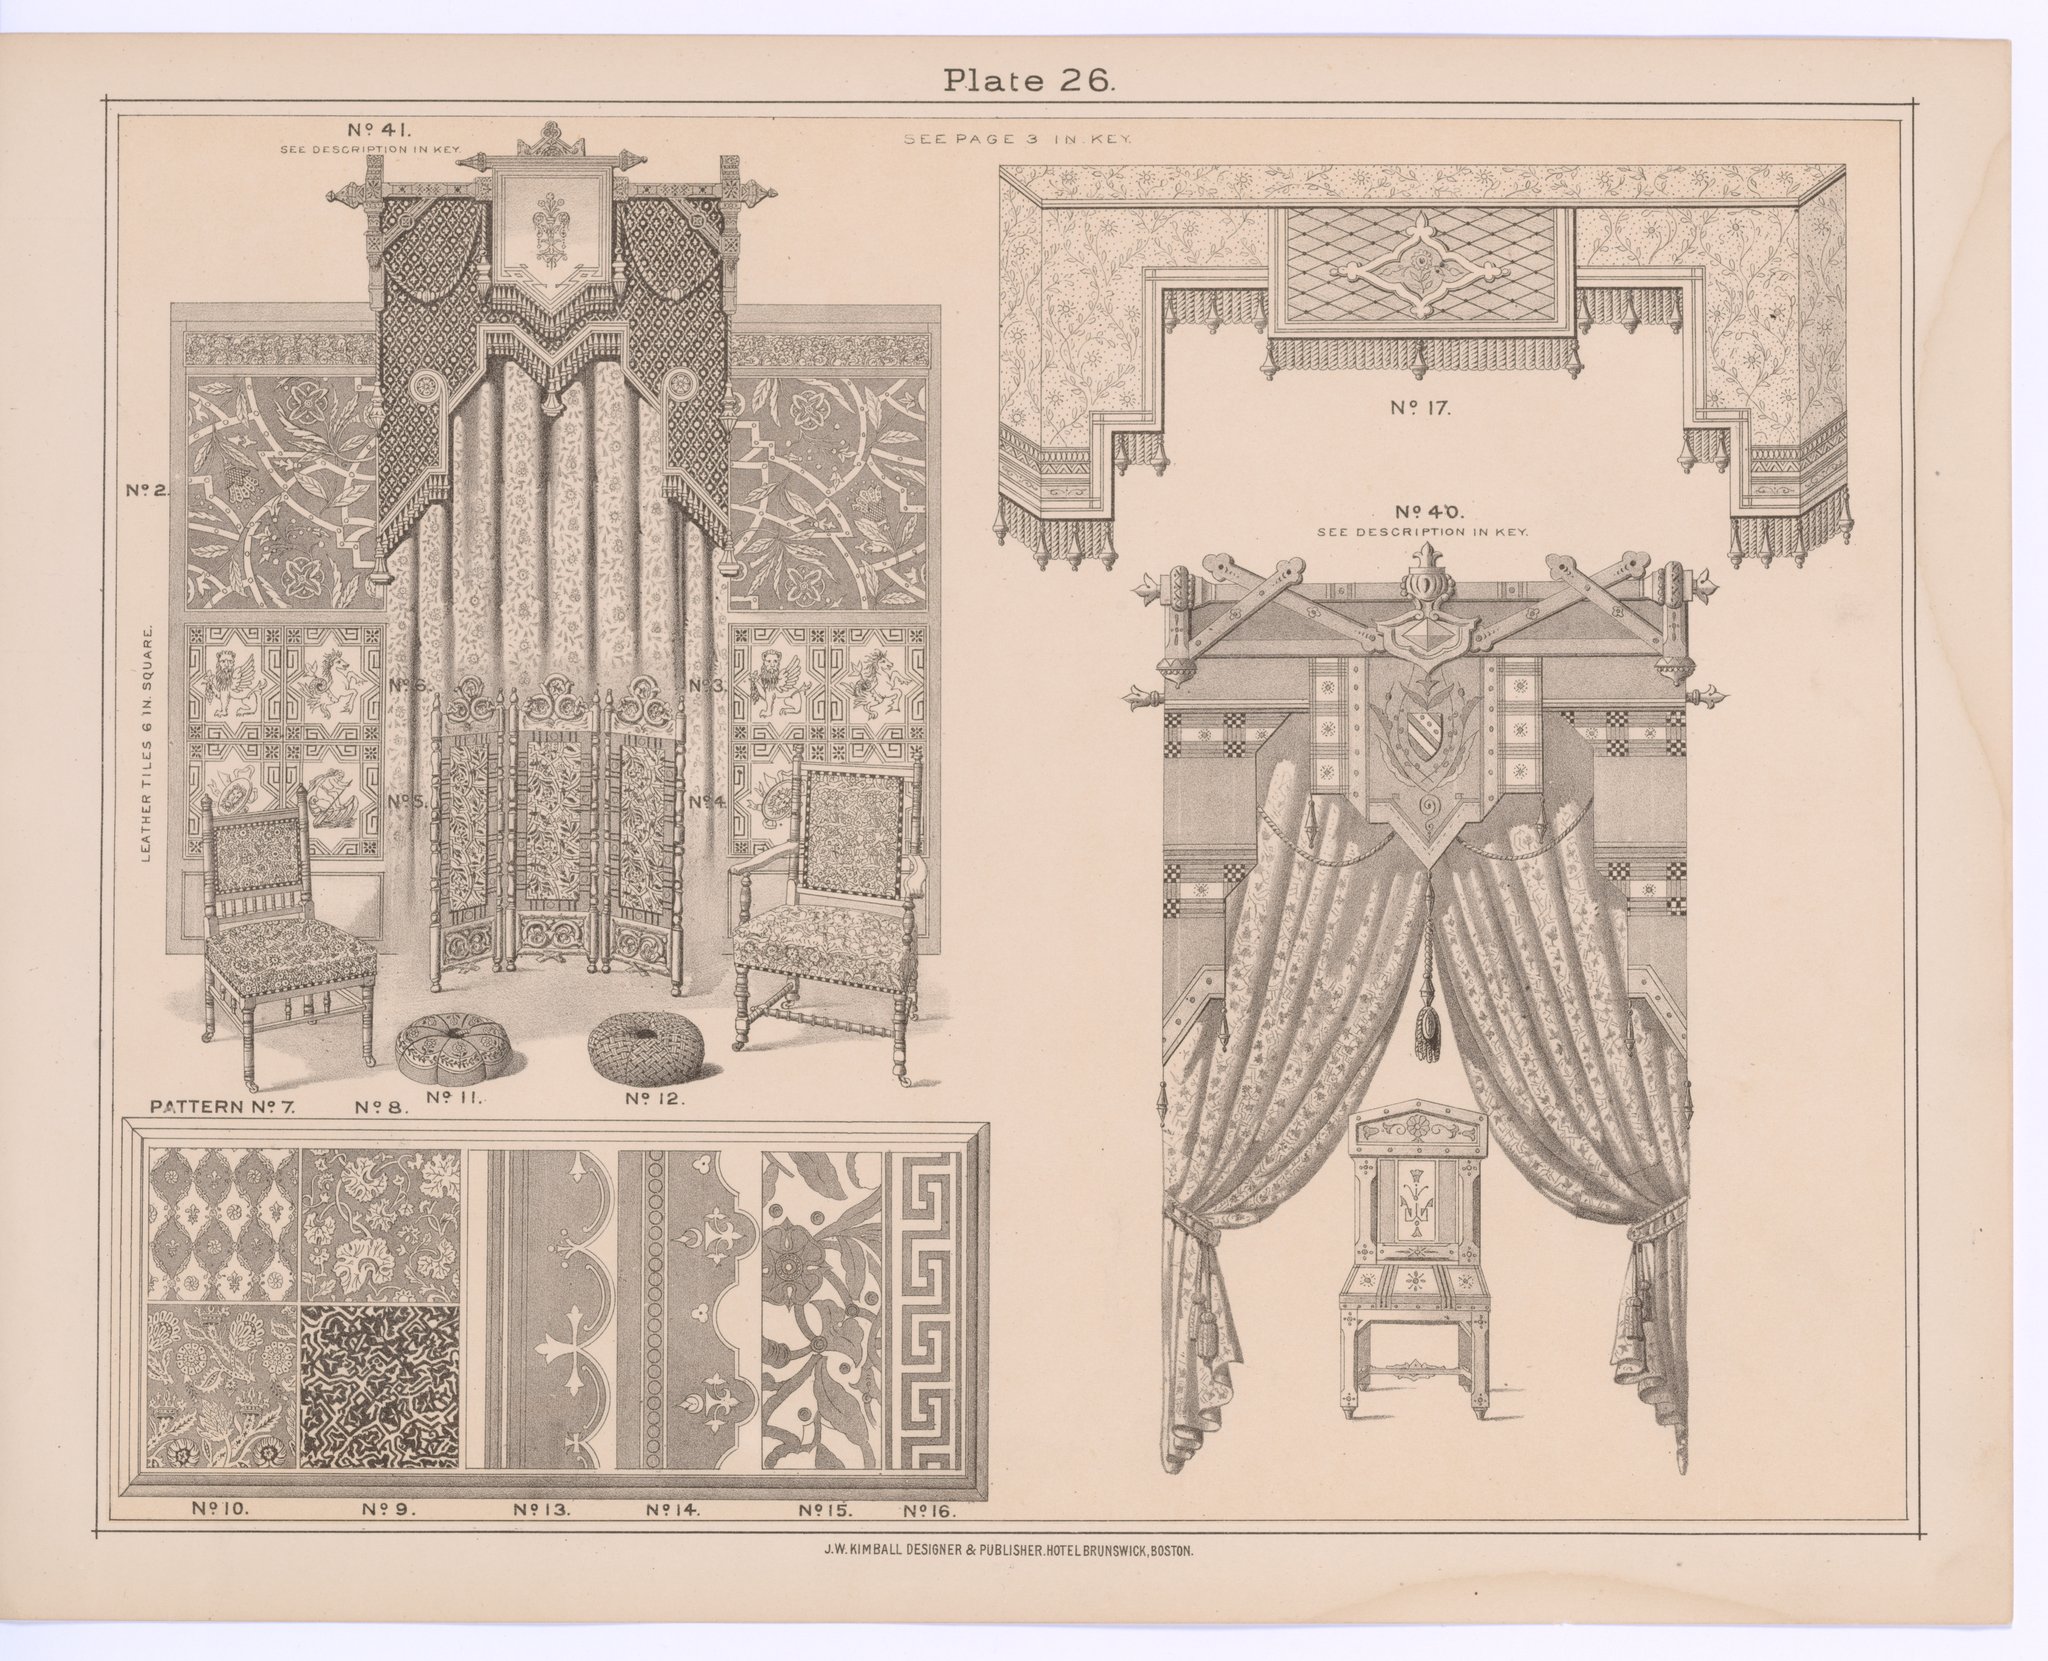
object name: book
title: Kimball's Book of Designs: Furniture and Drapery.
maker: j. w. kimball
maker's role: author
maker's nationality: american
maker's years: 1850-1900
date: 1876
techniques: lithograph